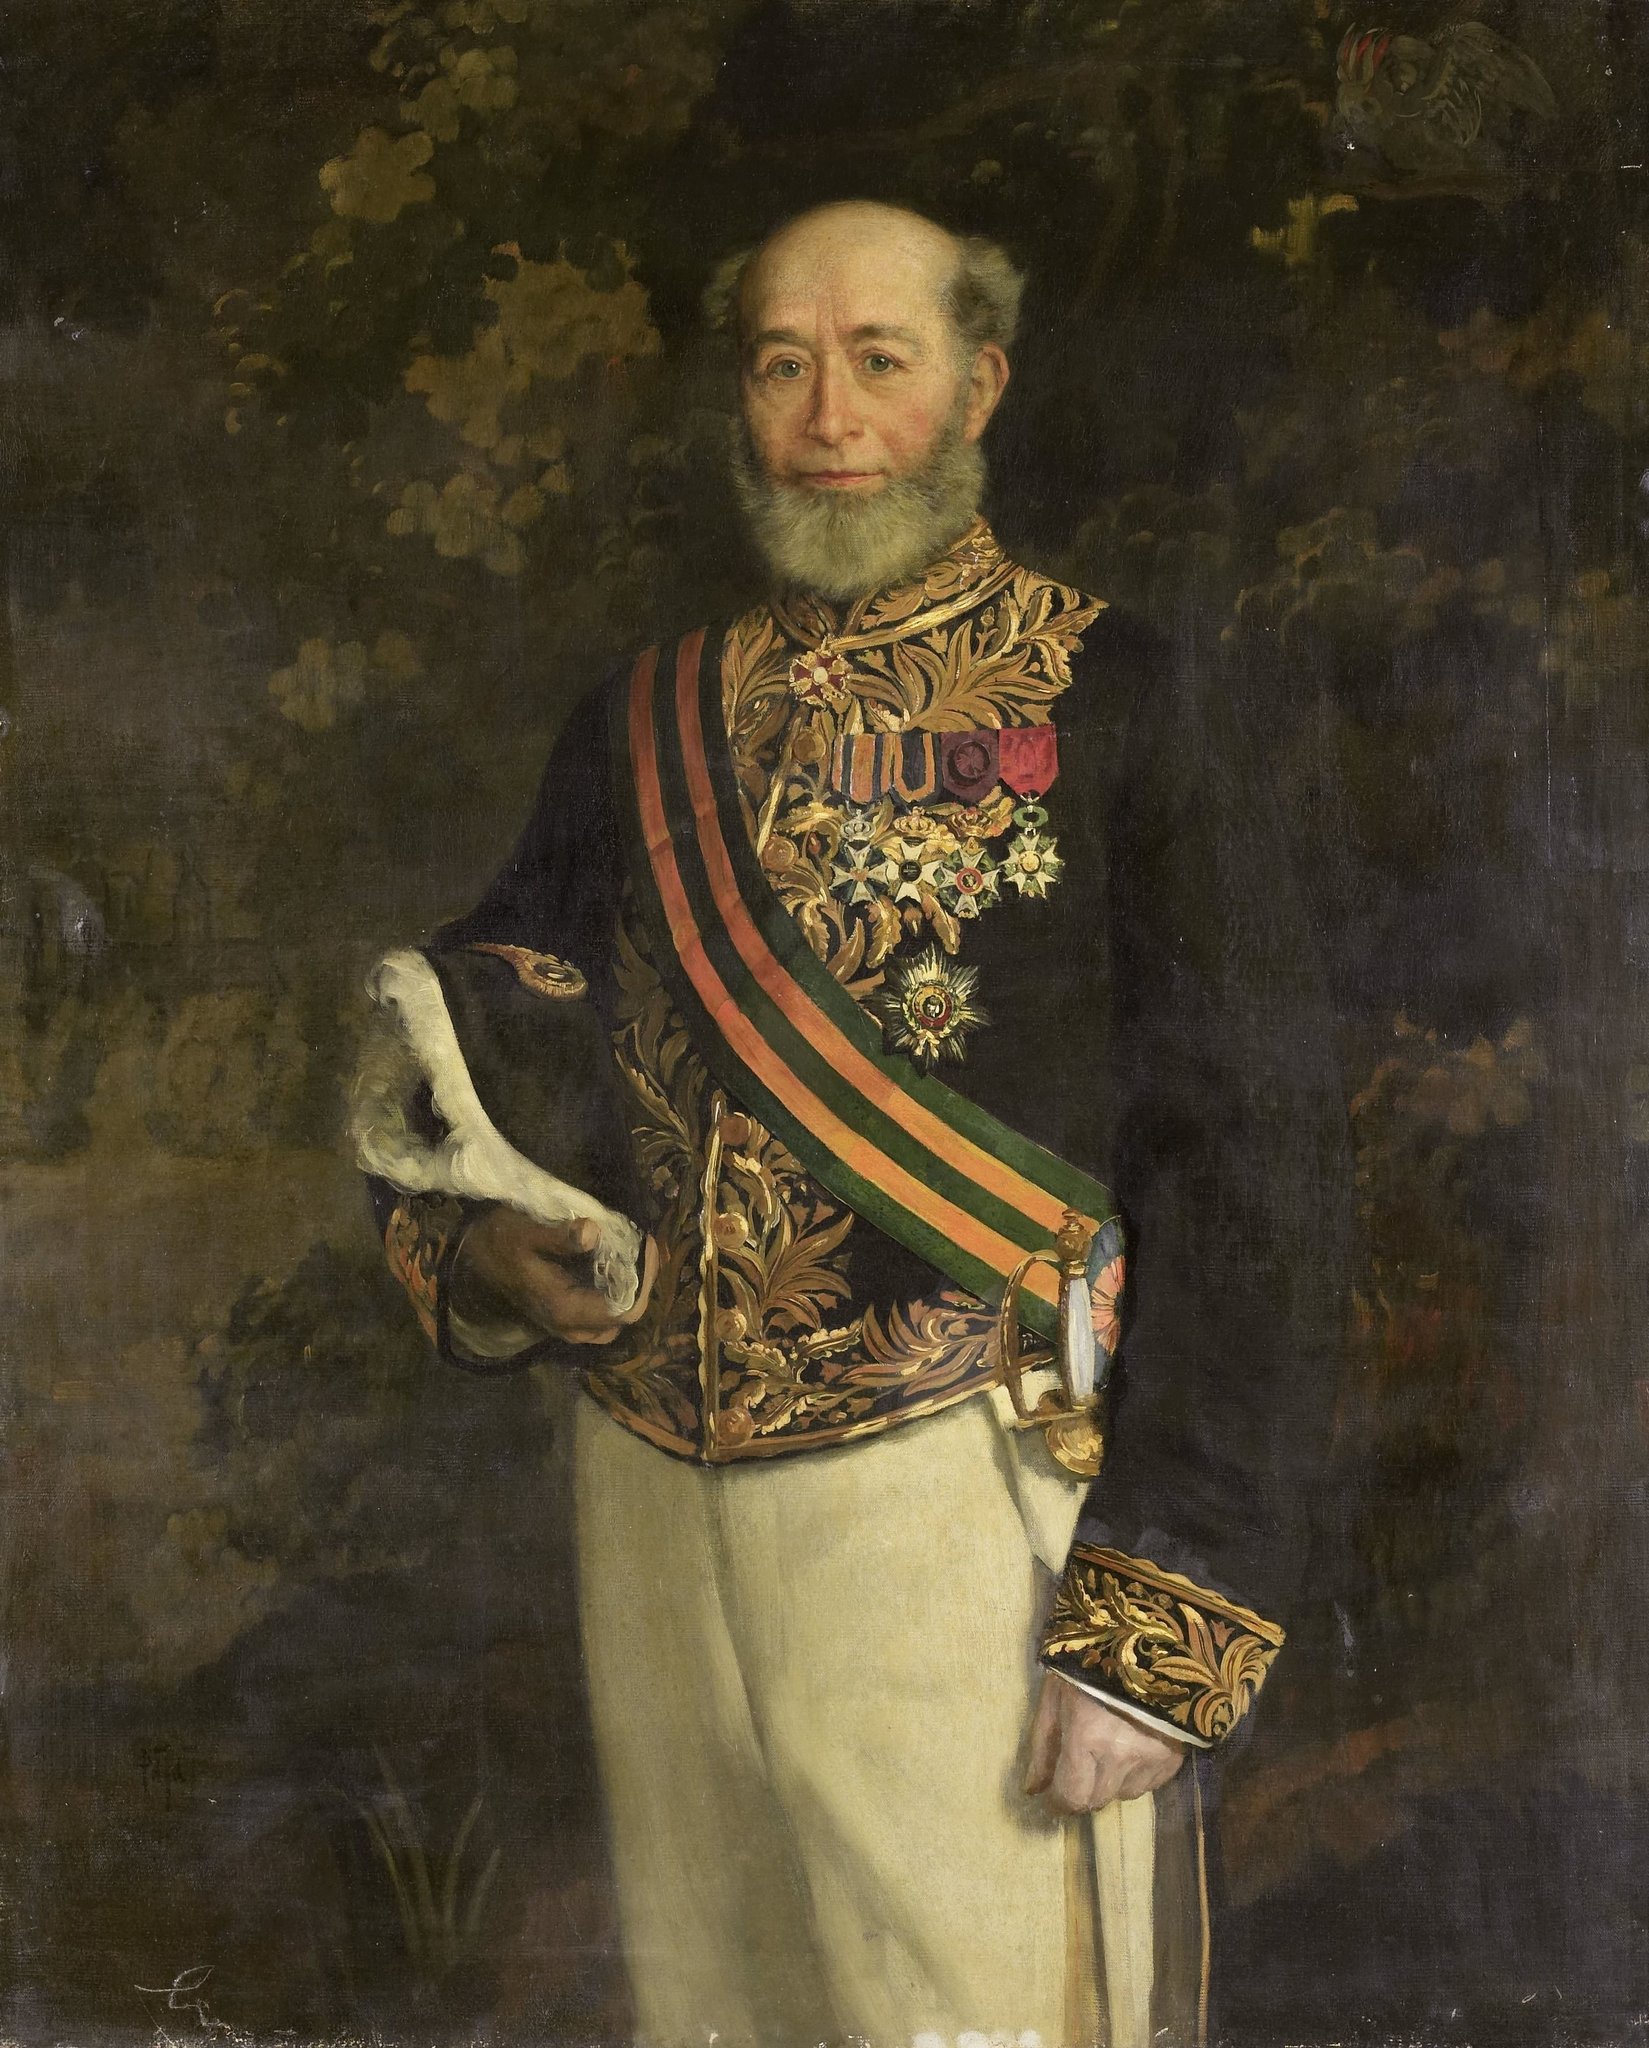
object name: painting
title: Frederik s'Jacob (1822-1901). Gouverneur-generaal (1880-84)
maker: pieter de josselin de jong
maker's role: draughtsman, painter, print maker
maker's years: 1861-1906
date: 1895-1896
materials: canvas, oil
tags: colonial governor, historical persons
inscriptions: signature: ‘P.d.J.d.J.’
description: Portret van Frederik s'Jacob (1822-1901). Gouverneur-generaal (1880-84). Kniestuk, staande met de steek in de rechterhand, iets naar links. Op de achtergrond een wandtapijt met gebladerte, een vogel en een gebouw. Onderdeel van een reeks van portretten van de gouverneurs-generaal van het voormalige Nederlands Oost-Indië.